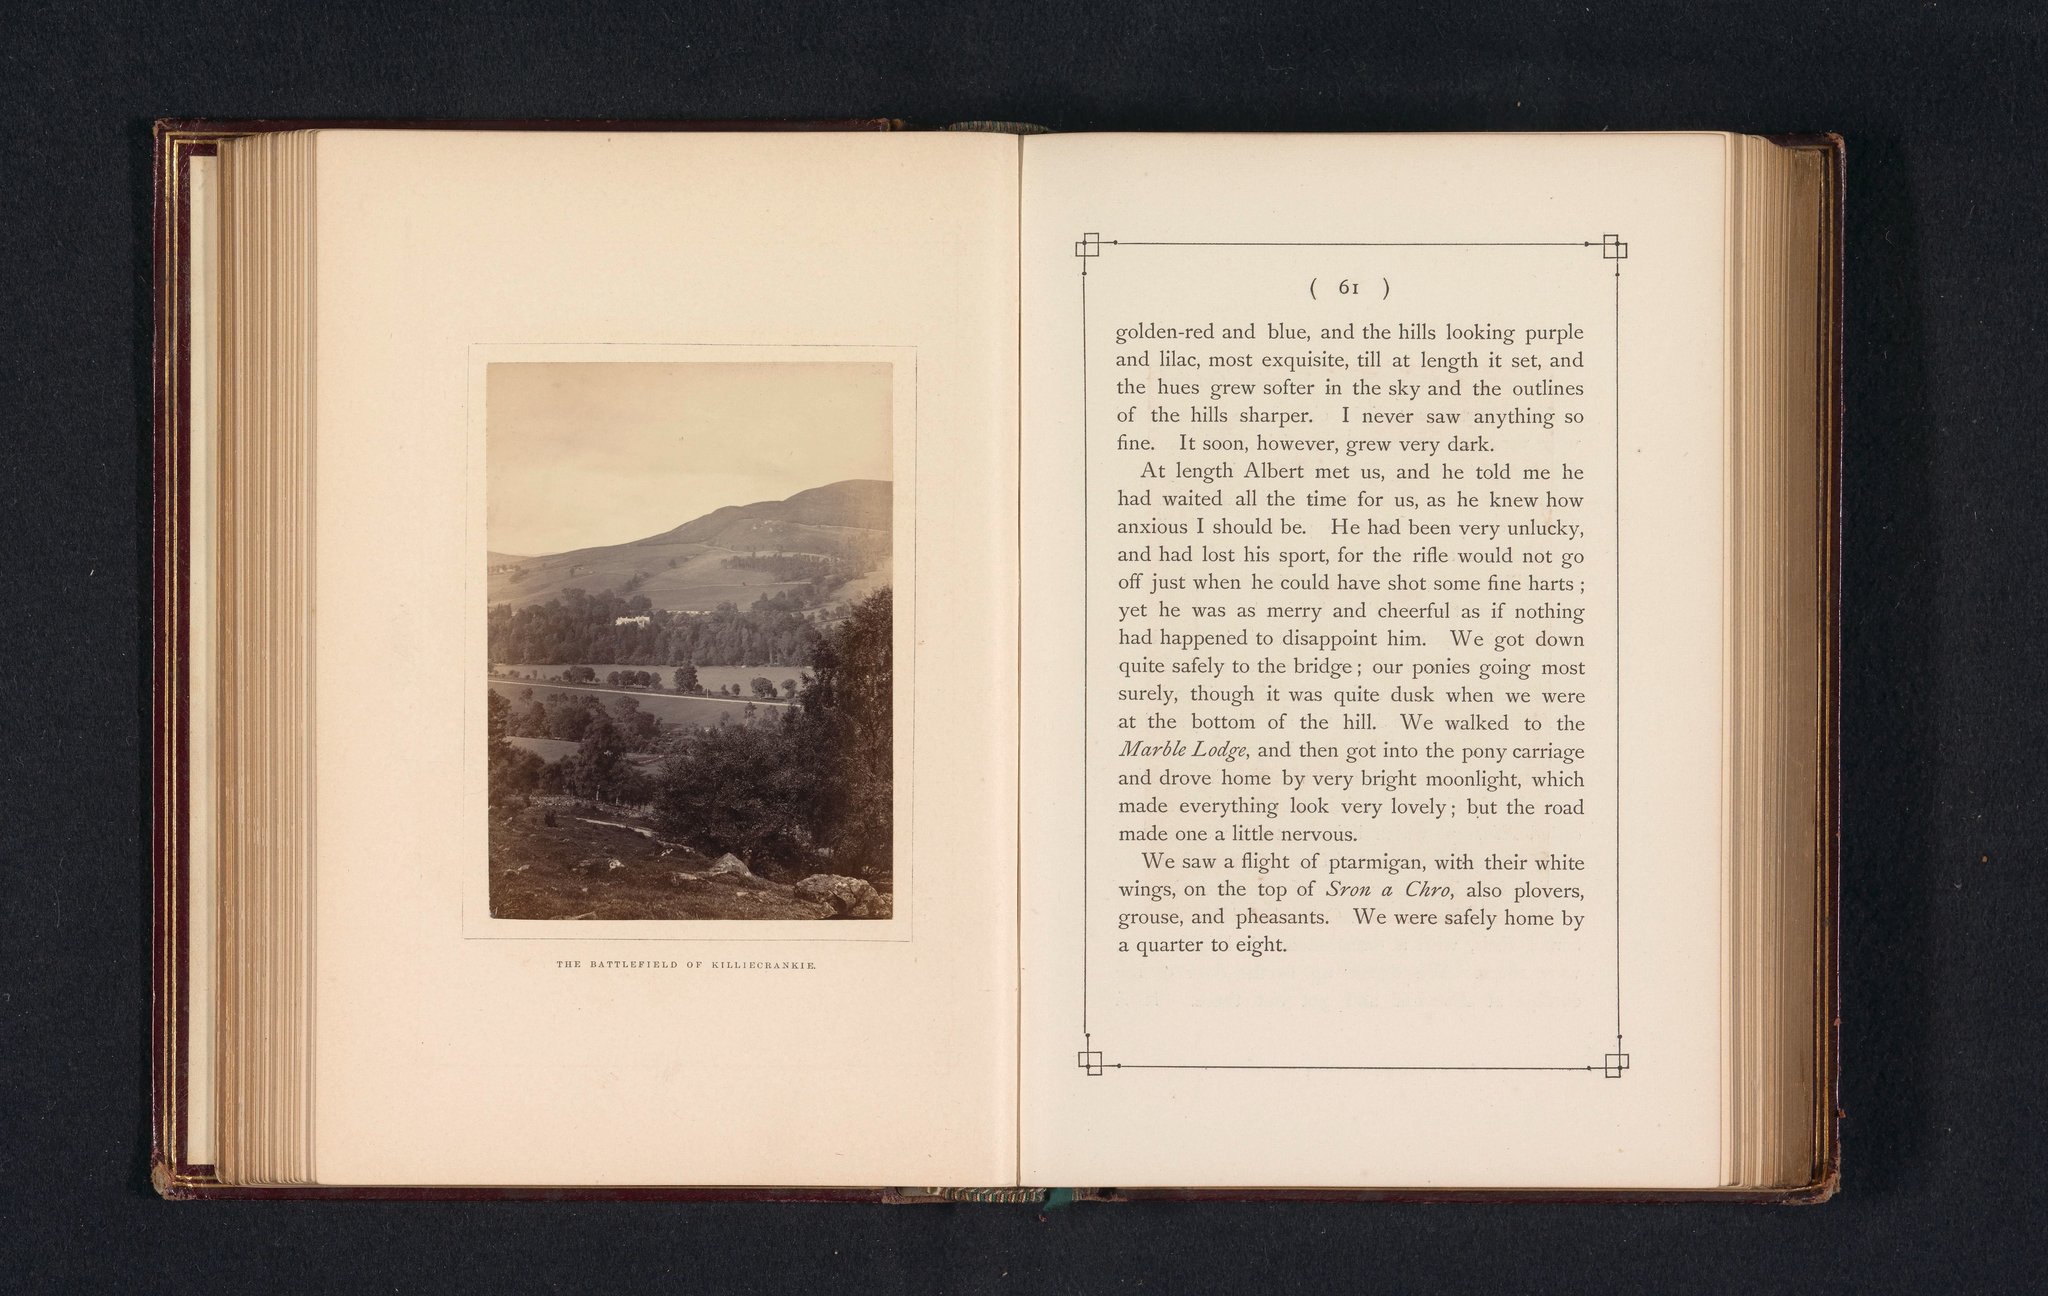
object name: page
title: The battlefield of Killiecrankie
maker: george washington wilson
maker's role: publisher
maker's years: 1823-1893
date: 1858-1868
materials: photographic support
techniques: albumen print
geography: killiecrankie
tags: dale, valley